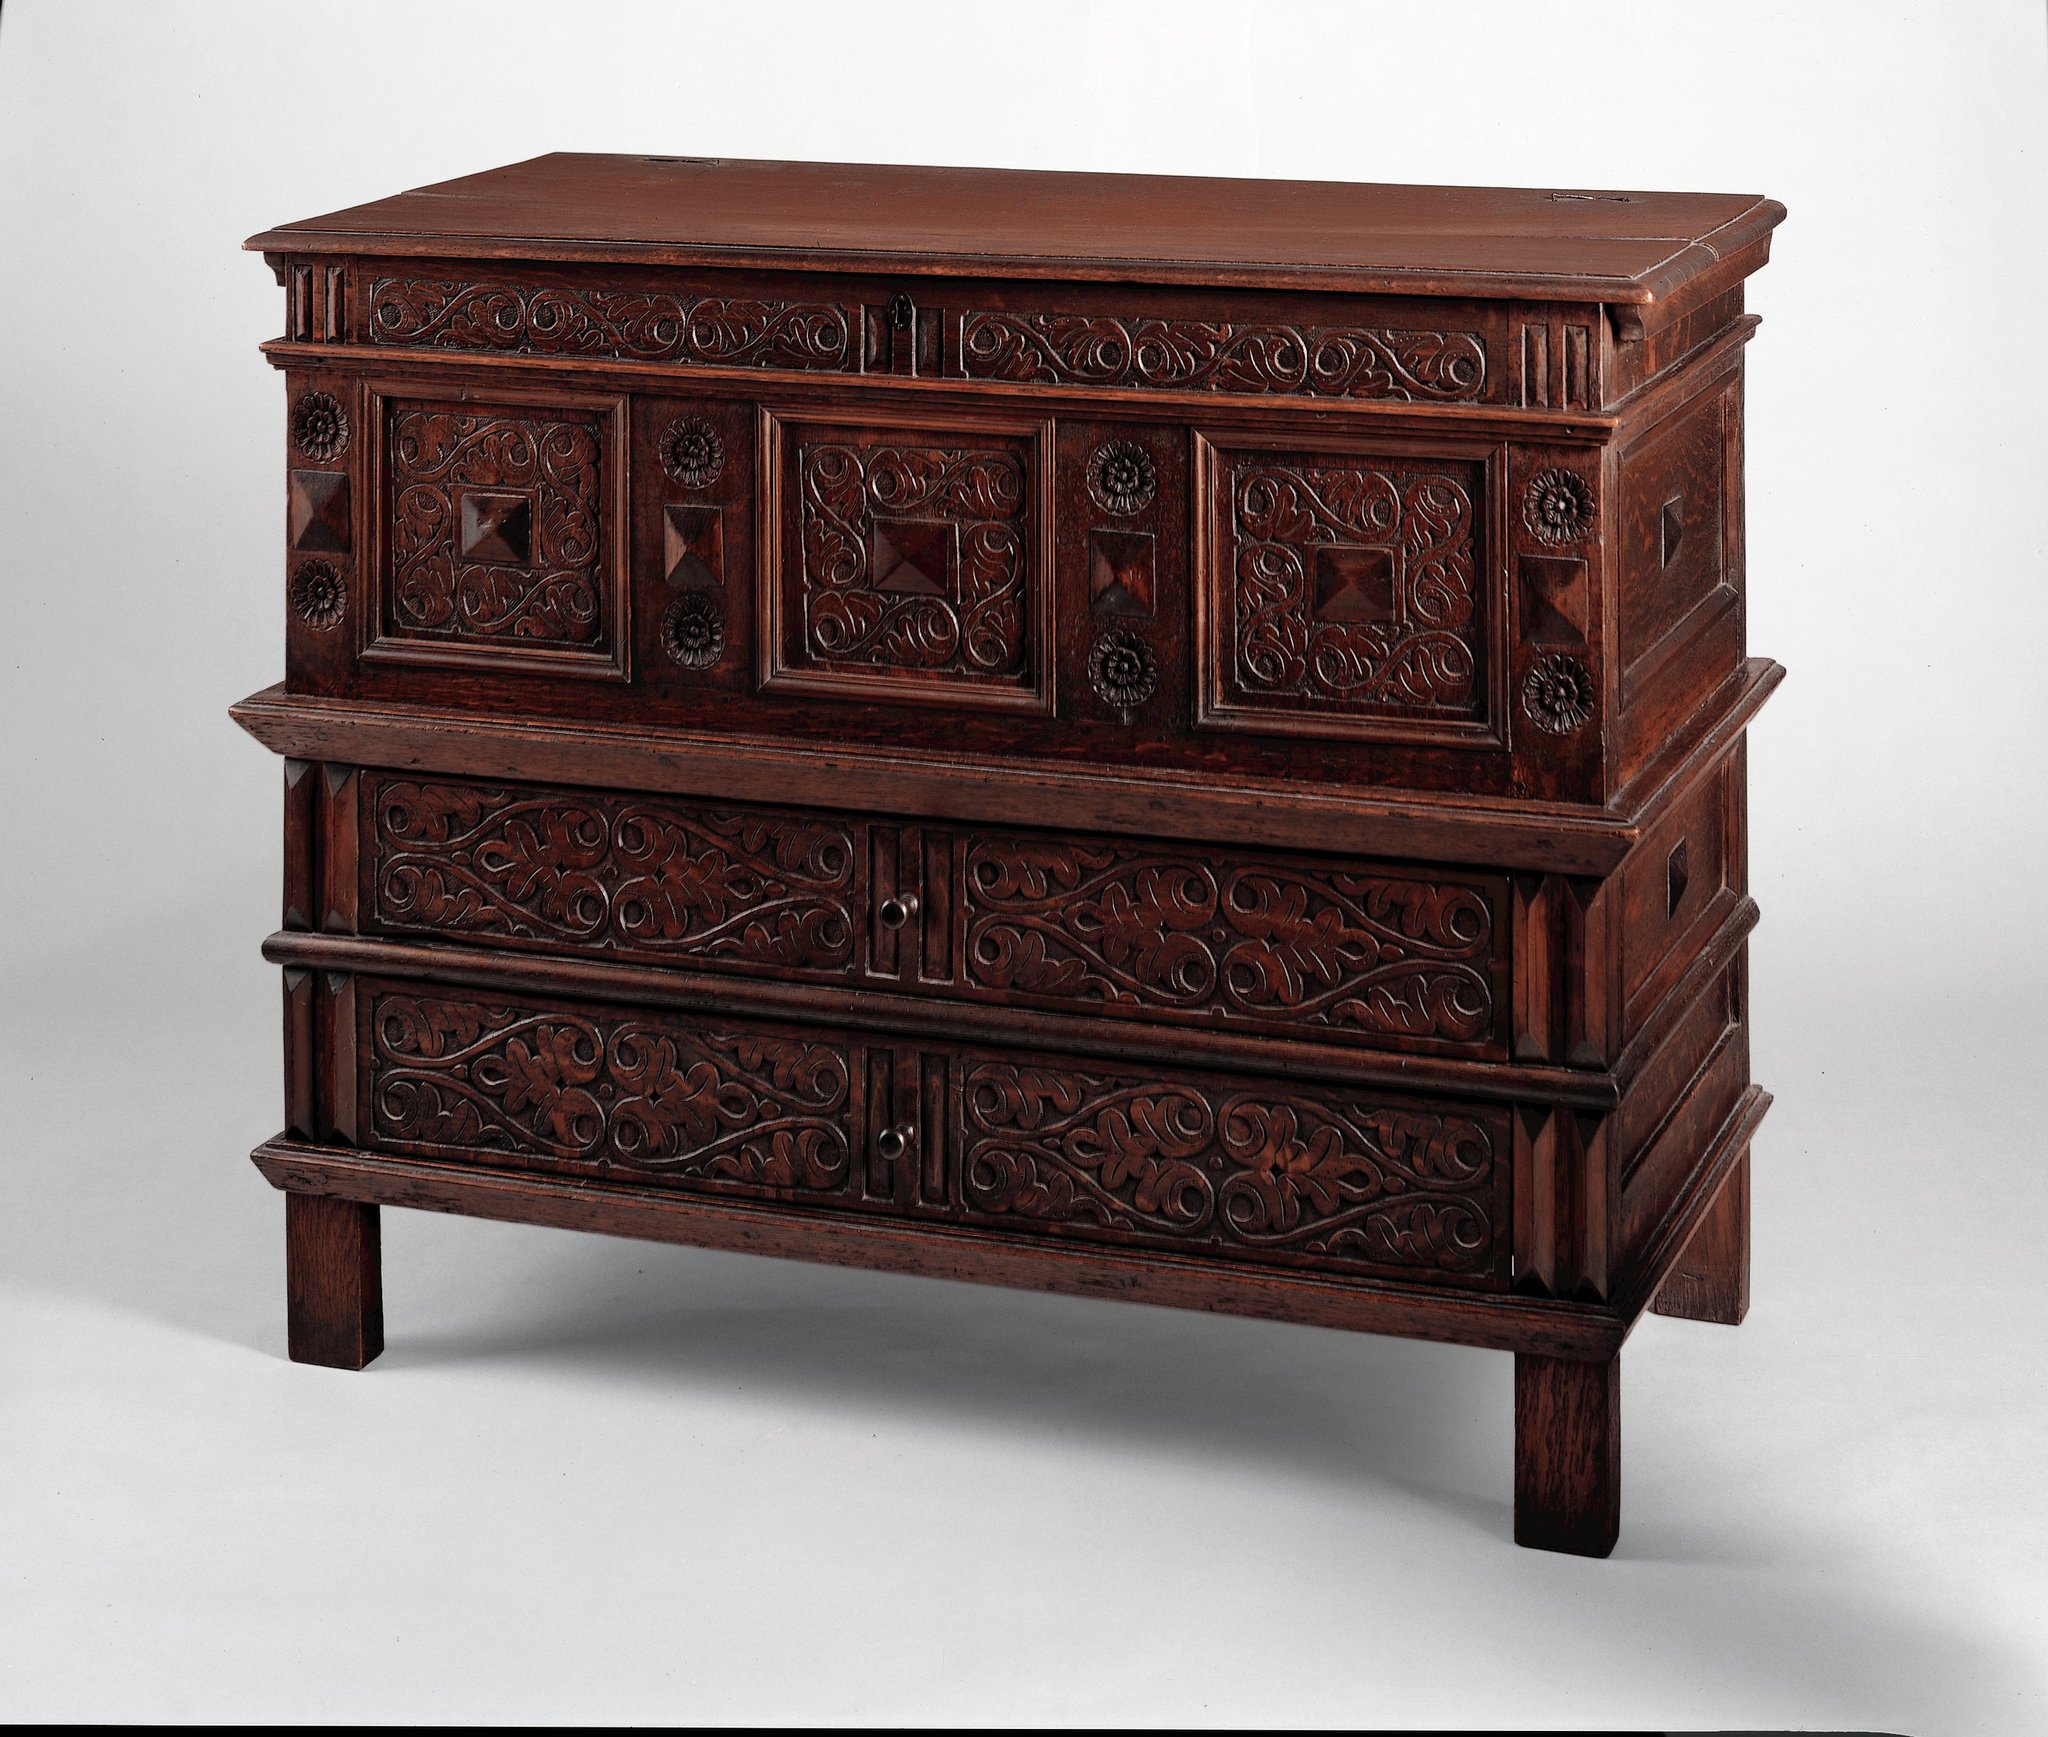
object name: chest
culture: american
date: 1650-1700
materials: wood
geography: united states